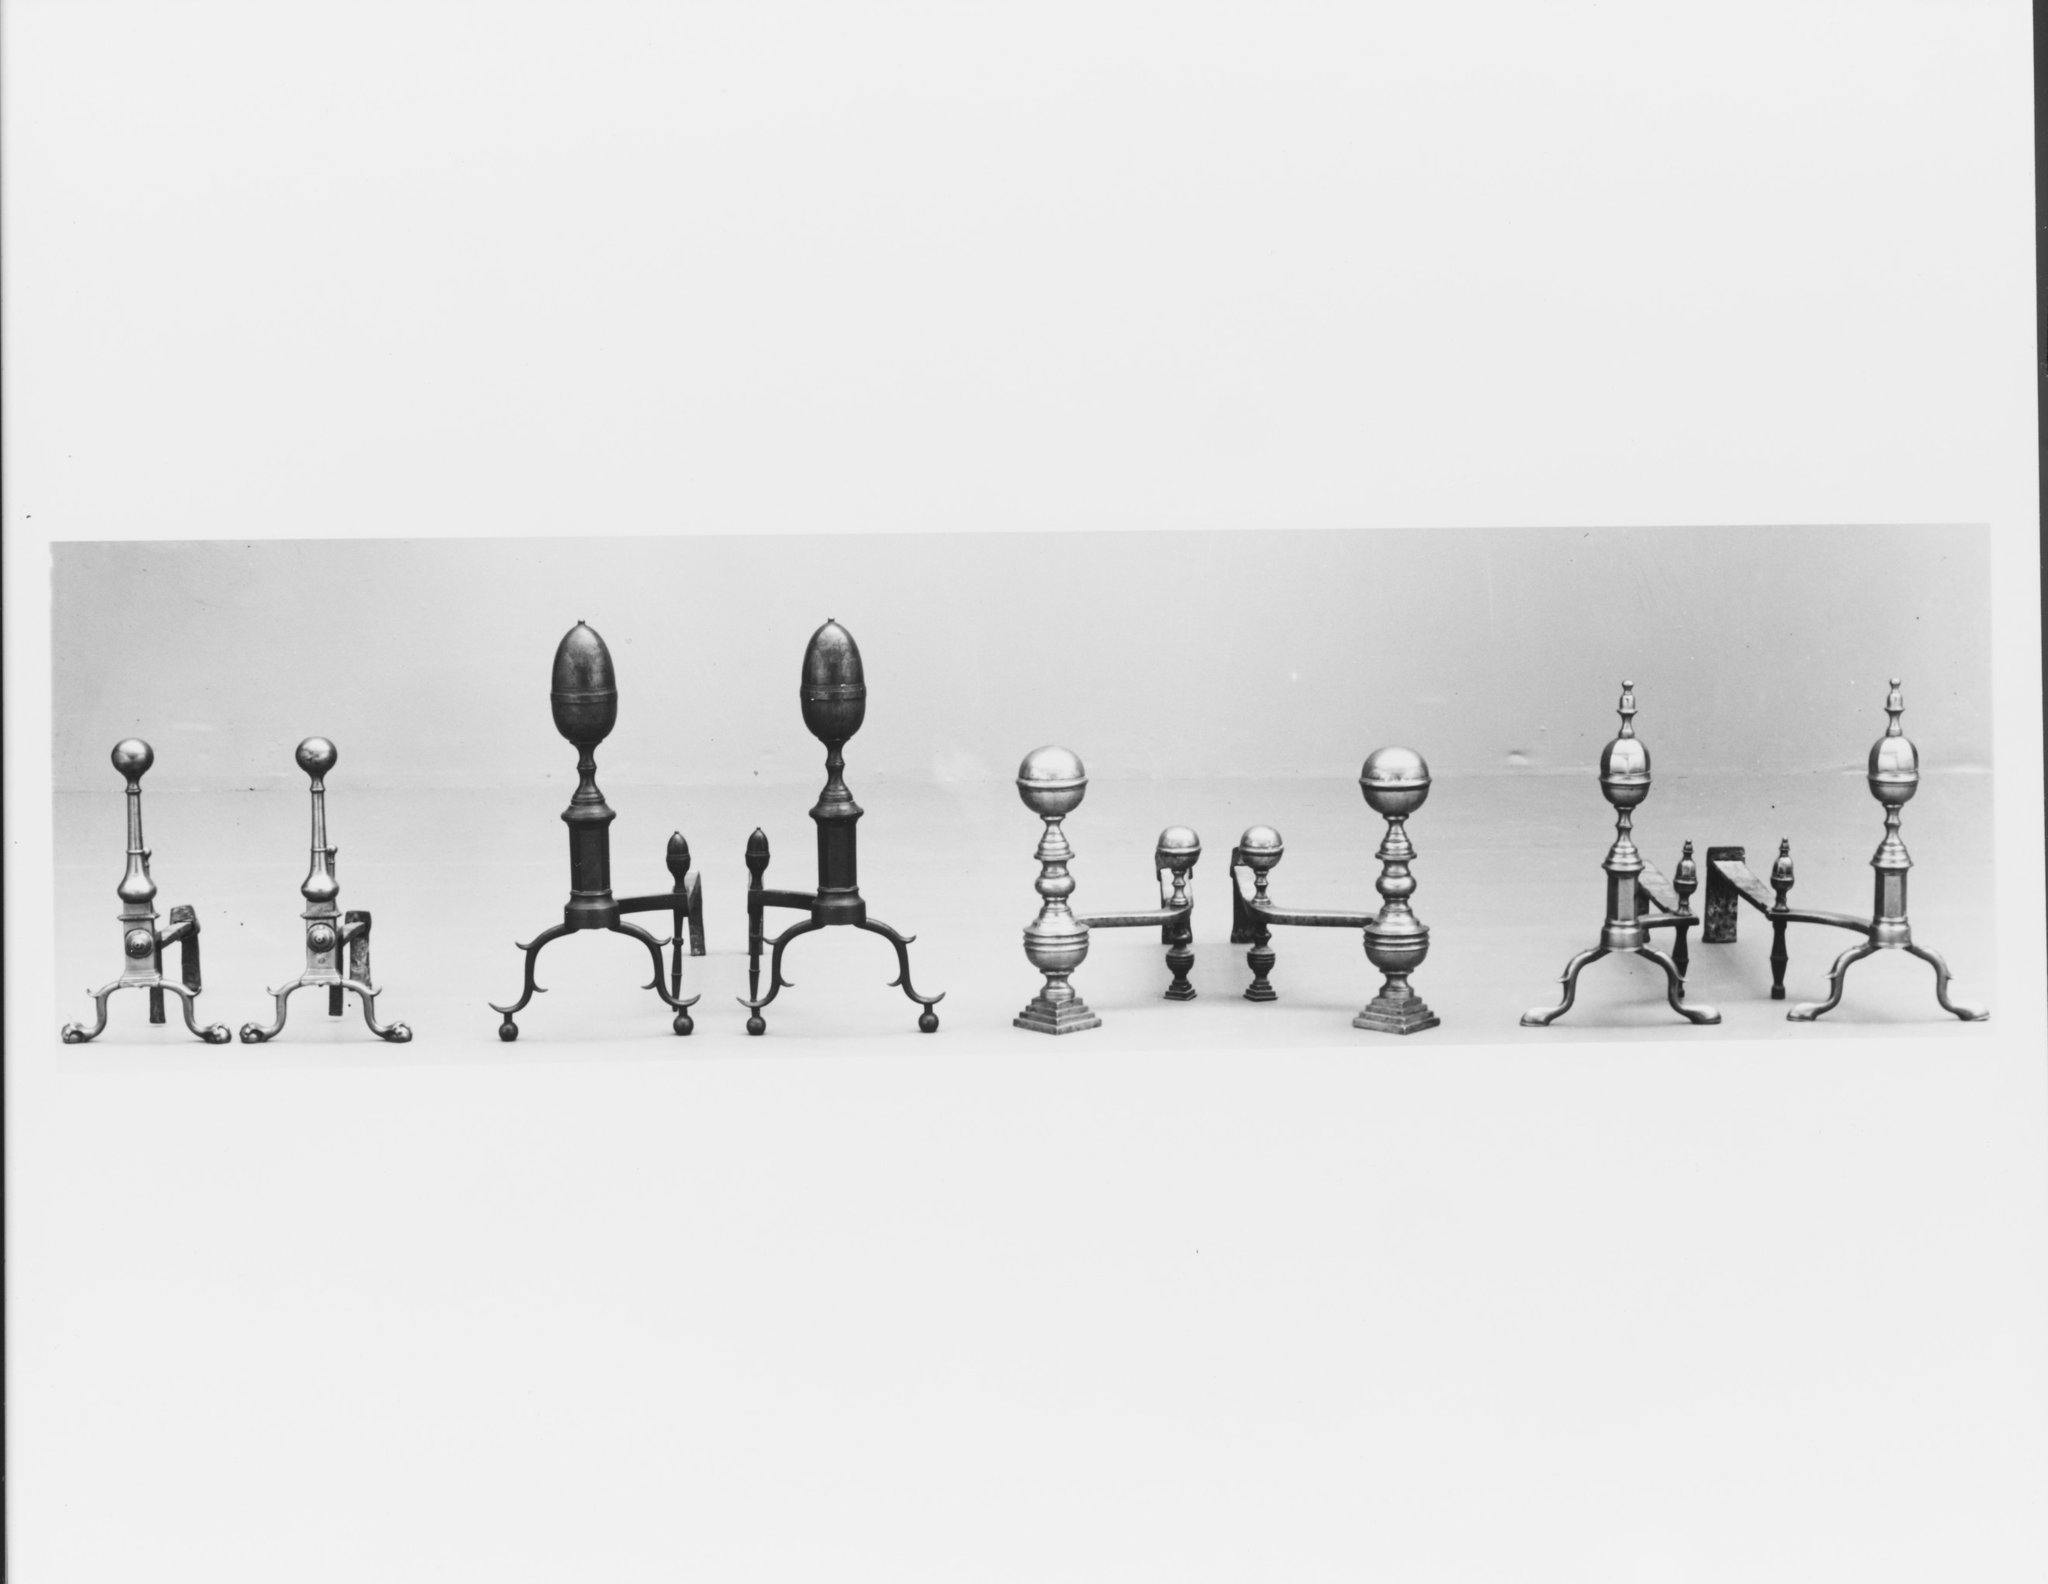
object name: andiron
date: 1700-1800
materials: brass